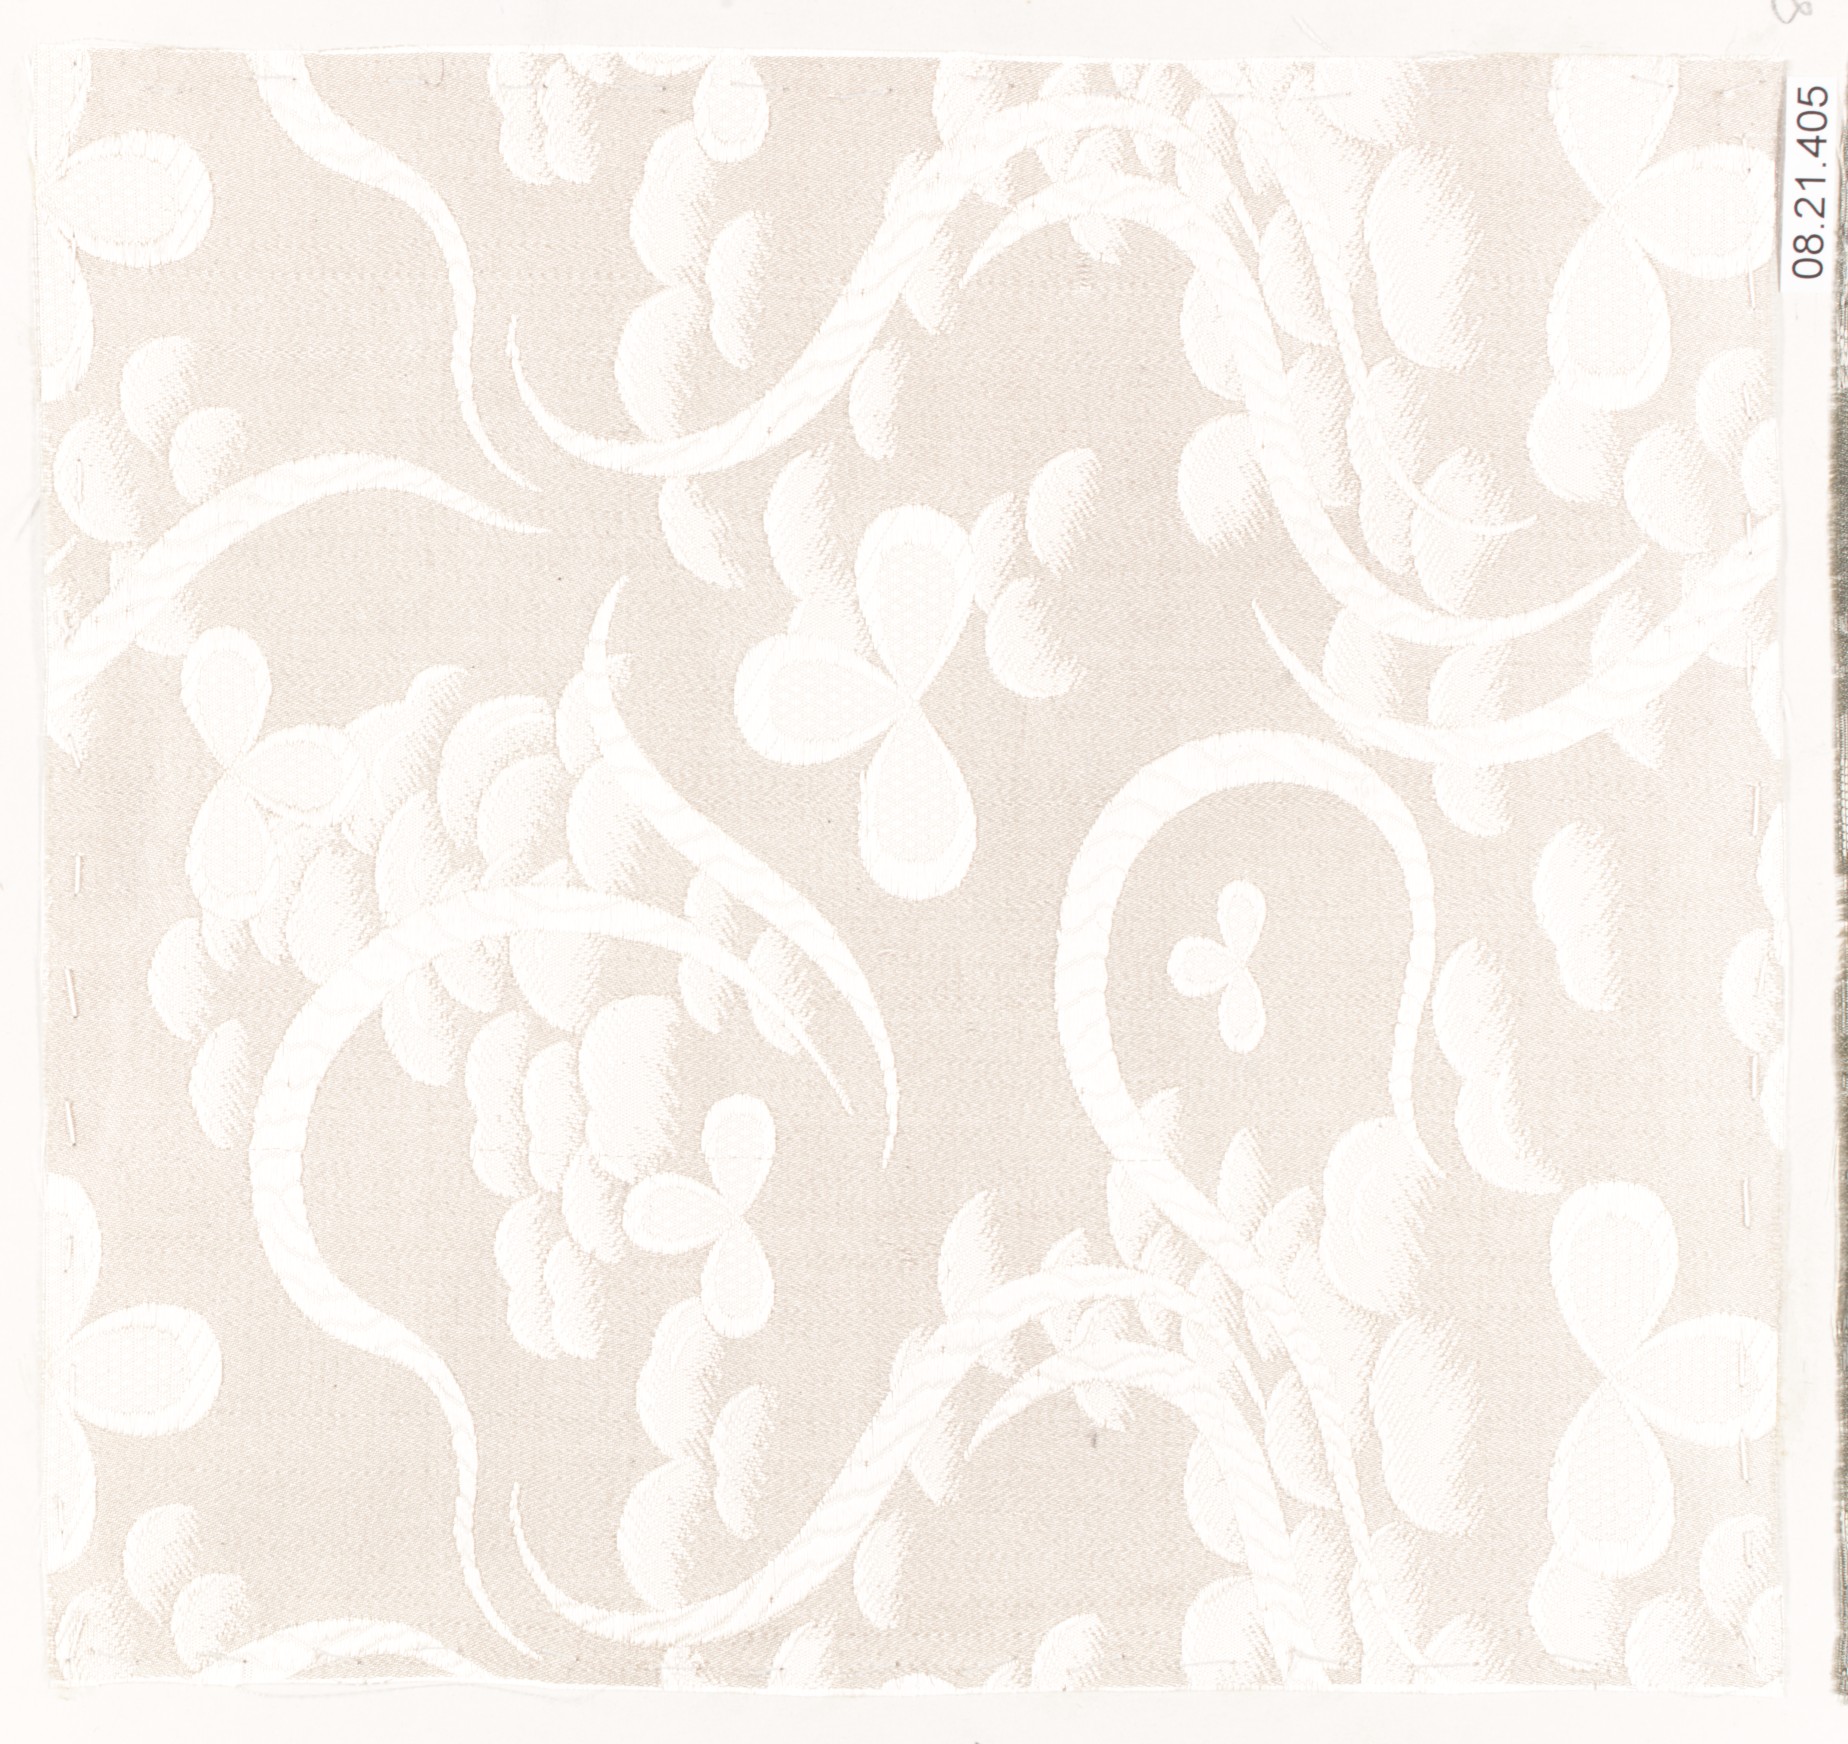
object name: textile sample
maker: Anonymous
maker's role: designer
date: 1900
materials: silk